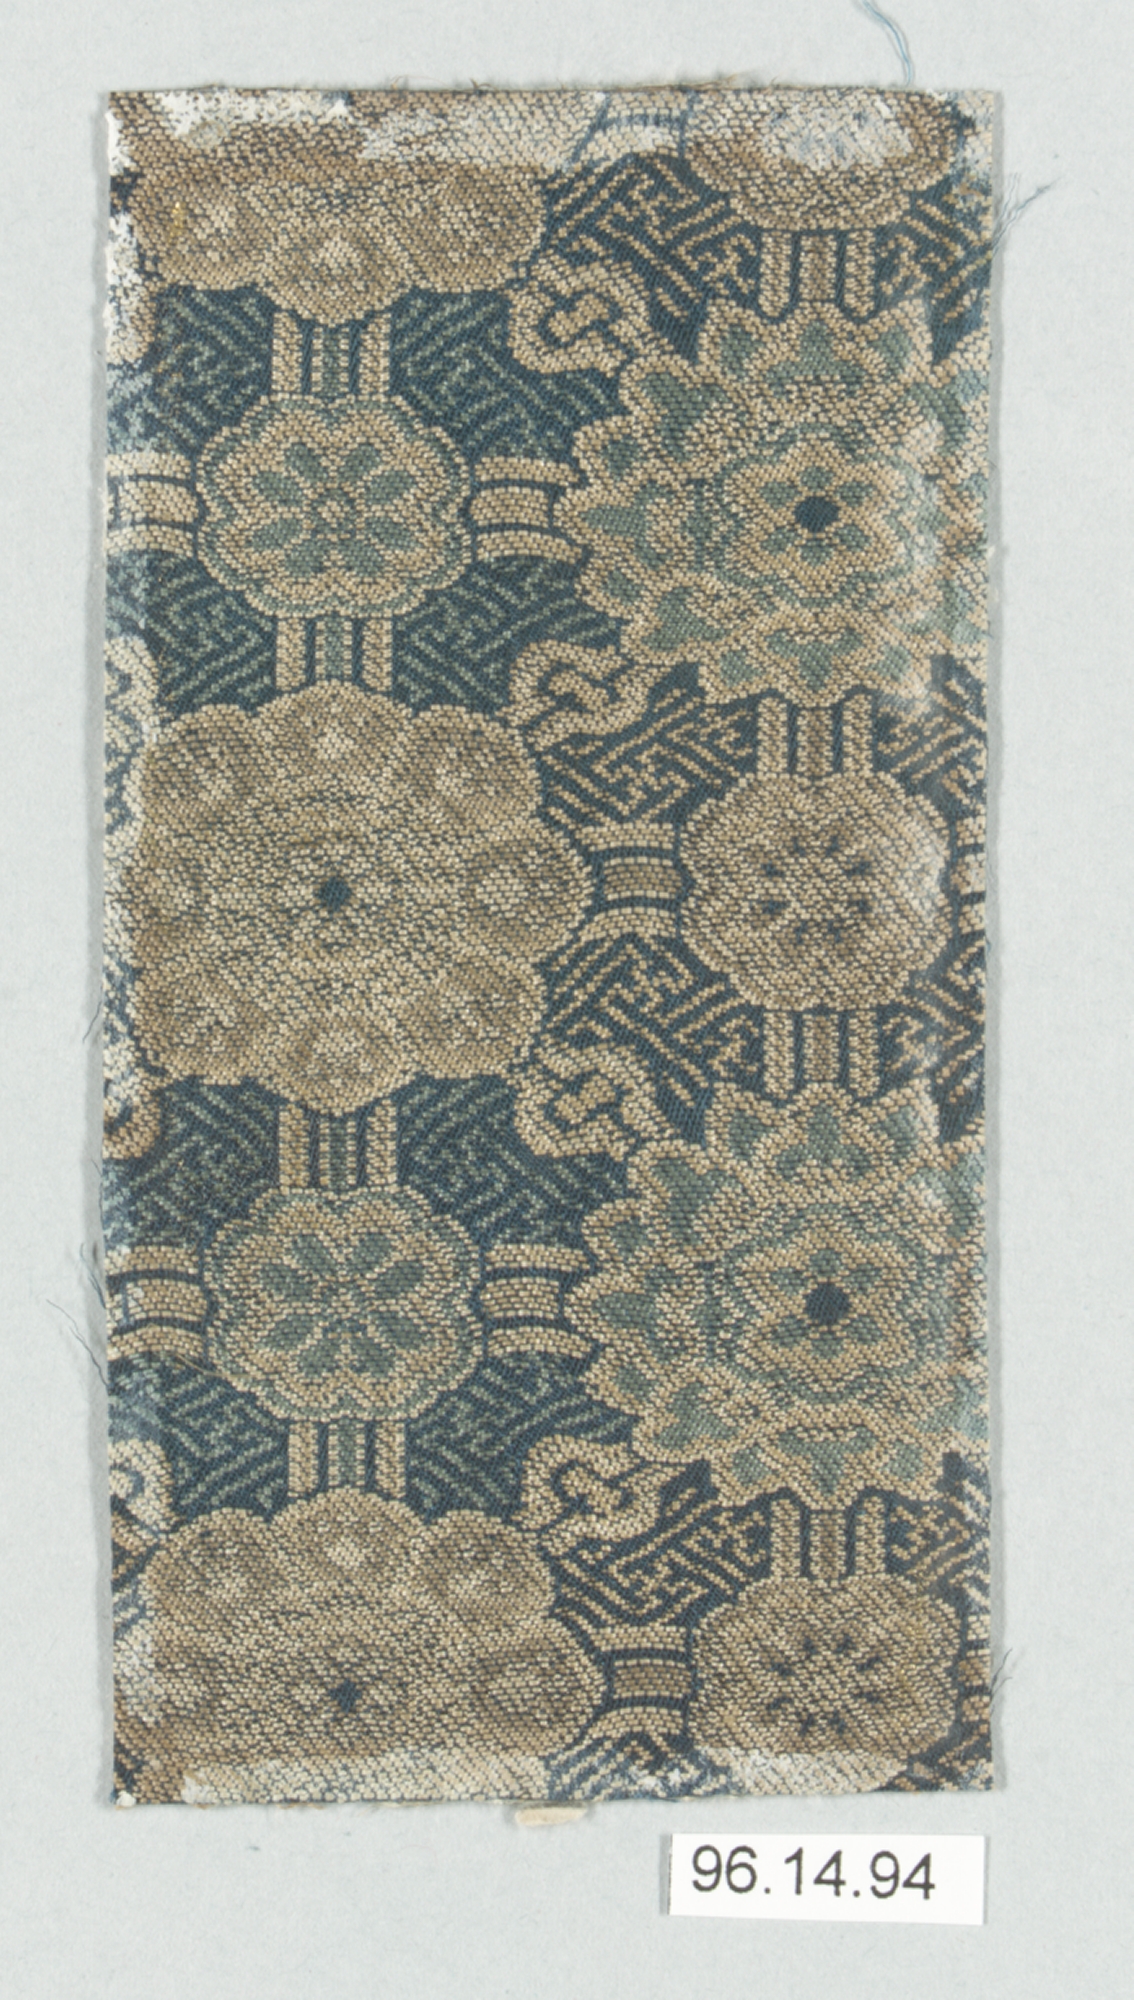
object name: piece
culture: japanese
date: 1701-1900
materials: silk